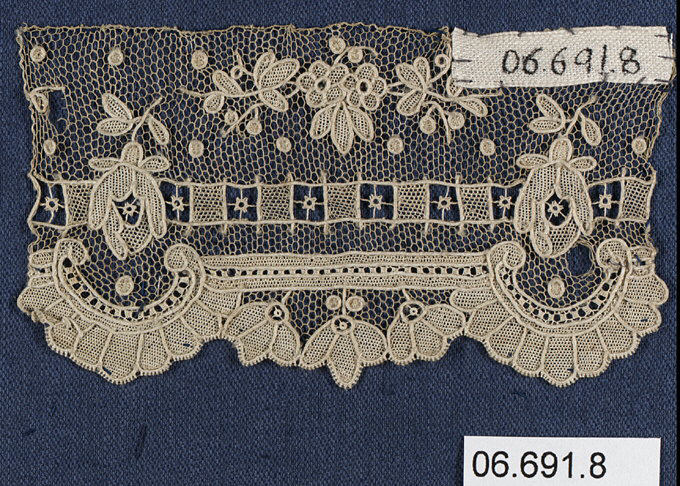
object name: sample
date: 1801-1900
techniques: lace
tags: flowers